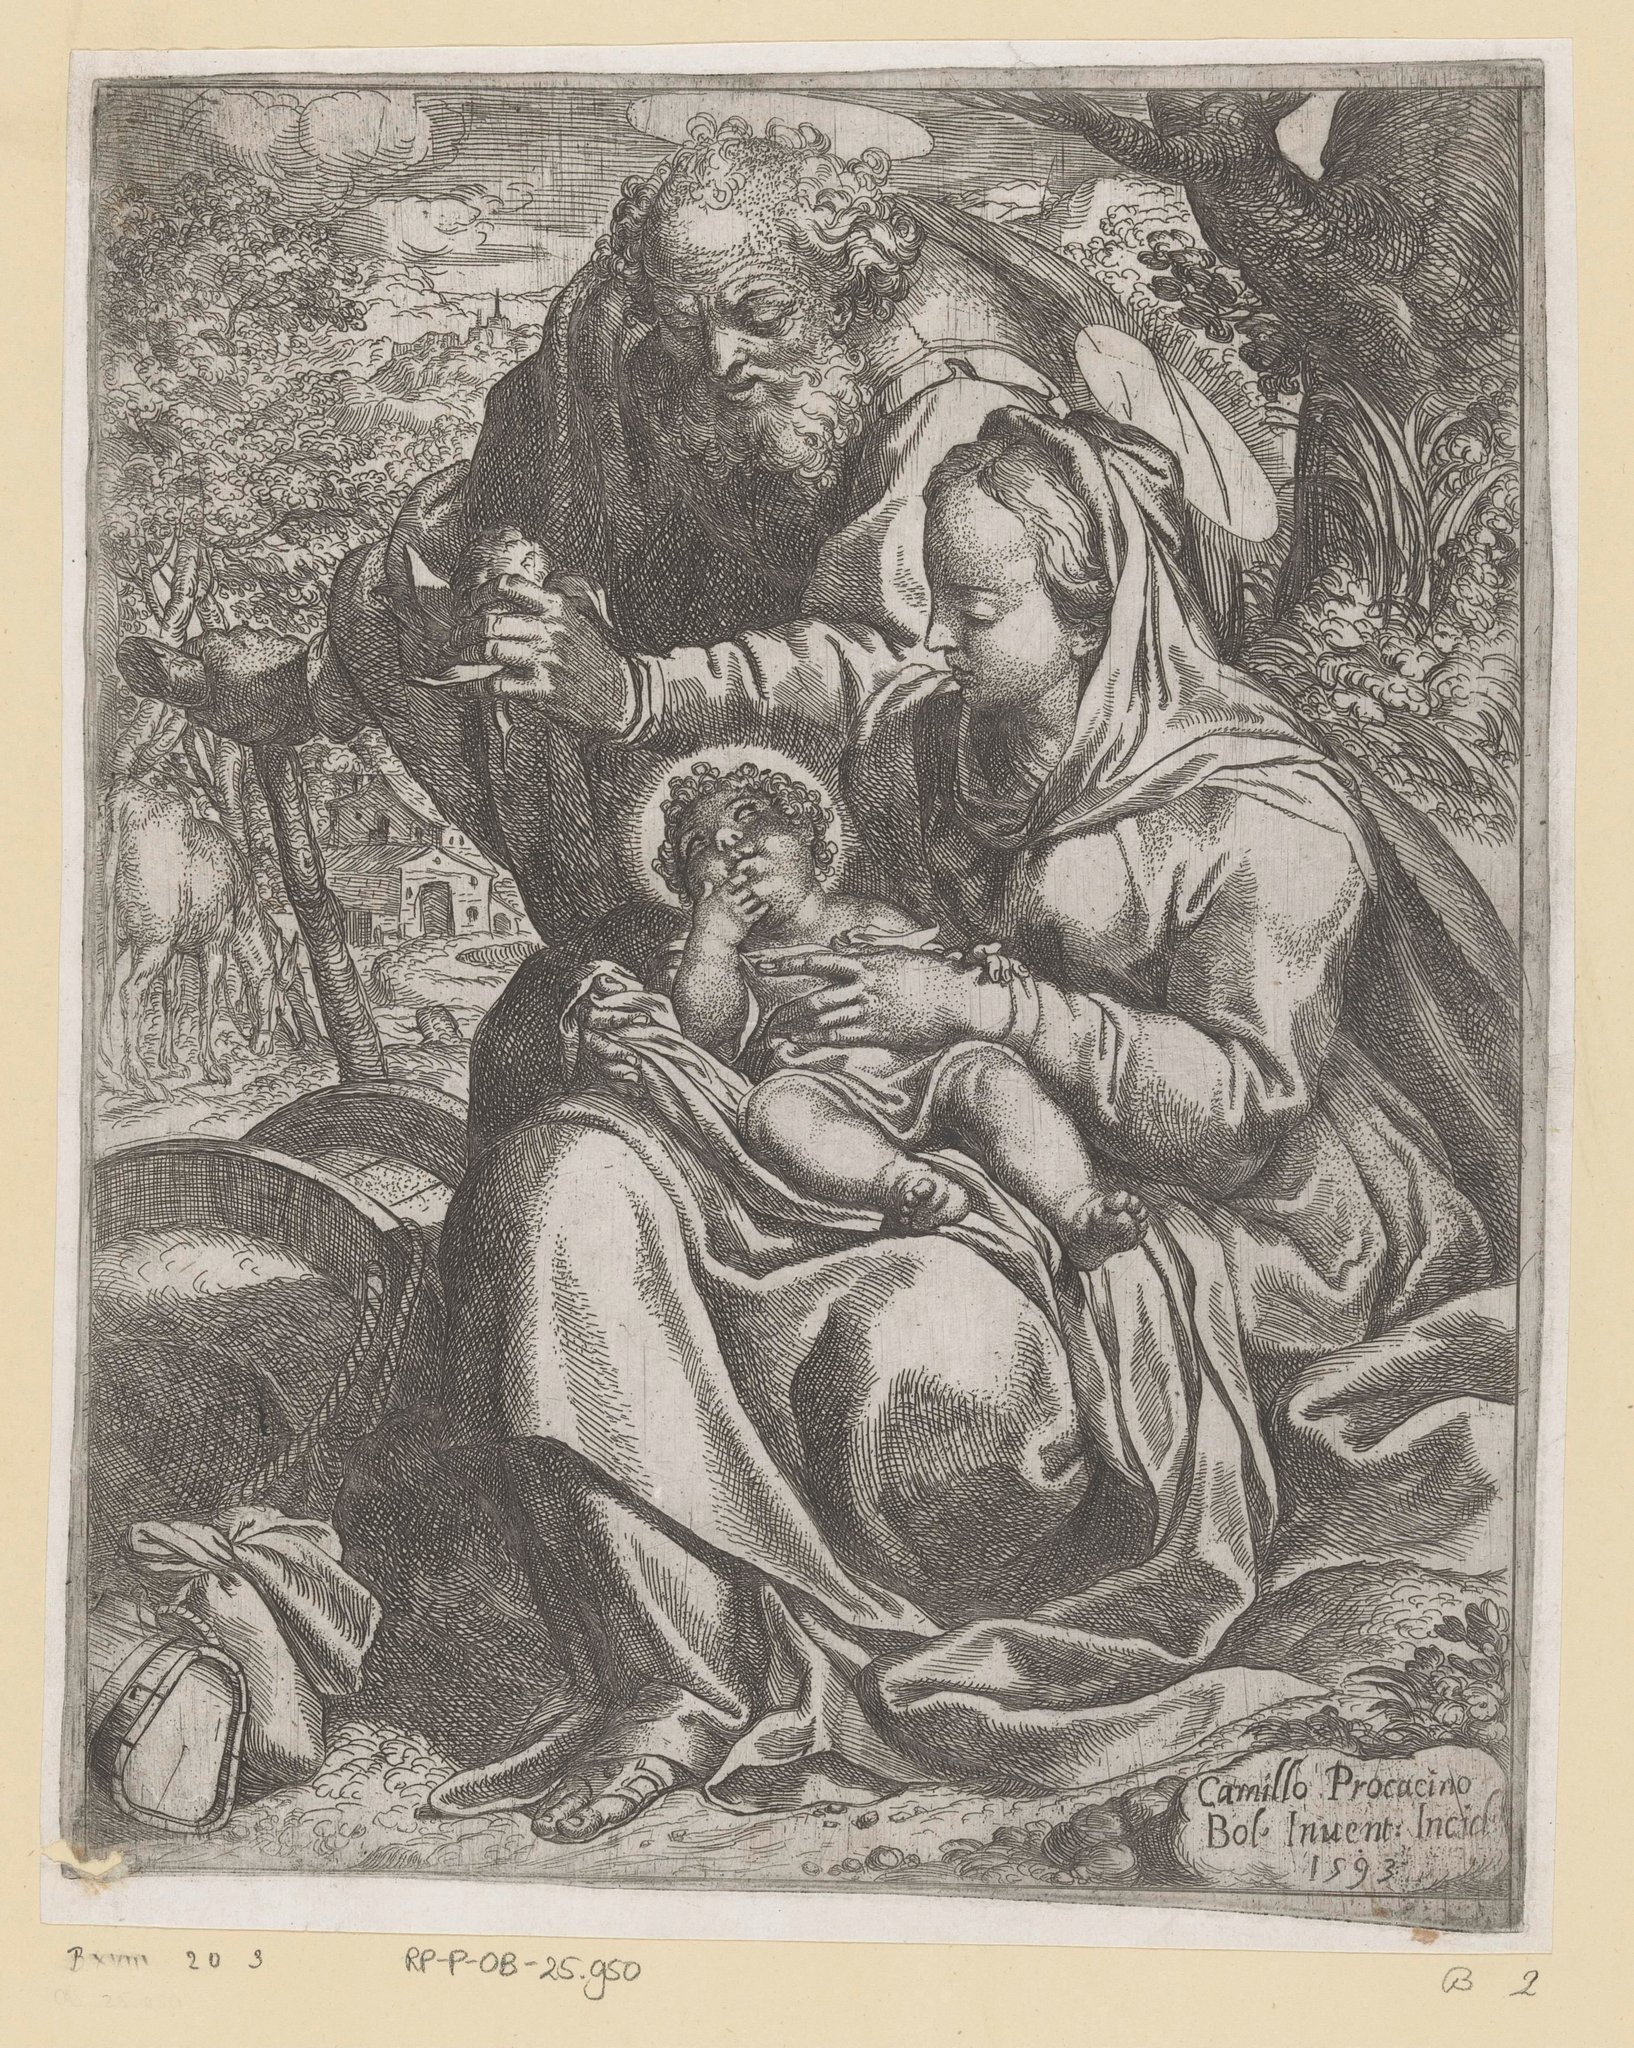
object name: print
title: Rest on the Flight into Egypt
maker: camillo procaccini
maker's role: painter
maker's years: 1555-1629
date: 1593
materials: paper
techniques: etching, intaglio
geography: bologna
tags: rest on the flight into egypt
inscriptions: collector's mark: Lugt 240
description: Maria zit met het Christuskind op schoot onder een boom. Jozef buigt over hen heen. Op de achtergrond staat de ezel te grazen.